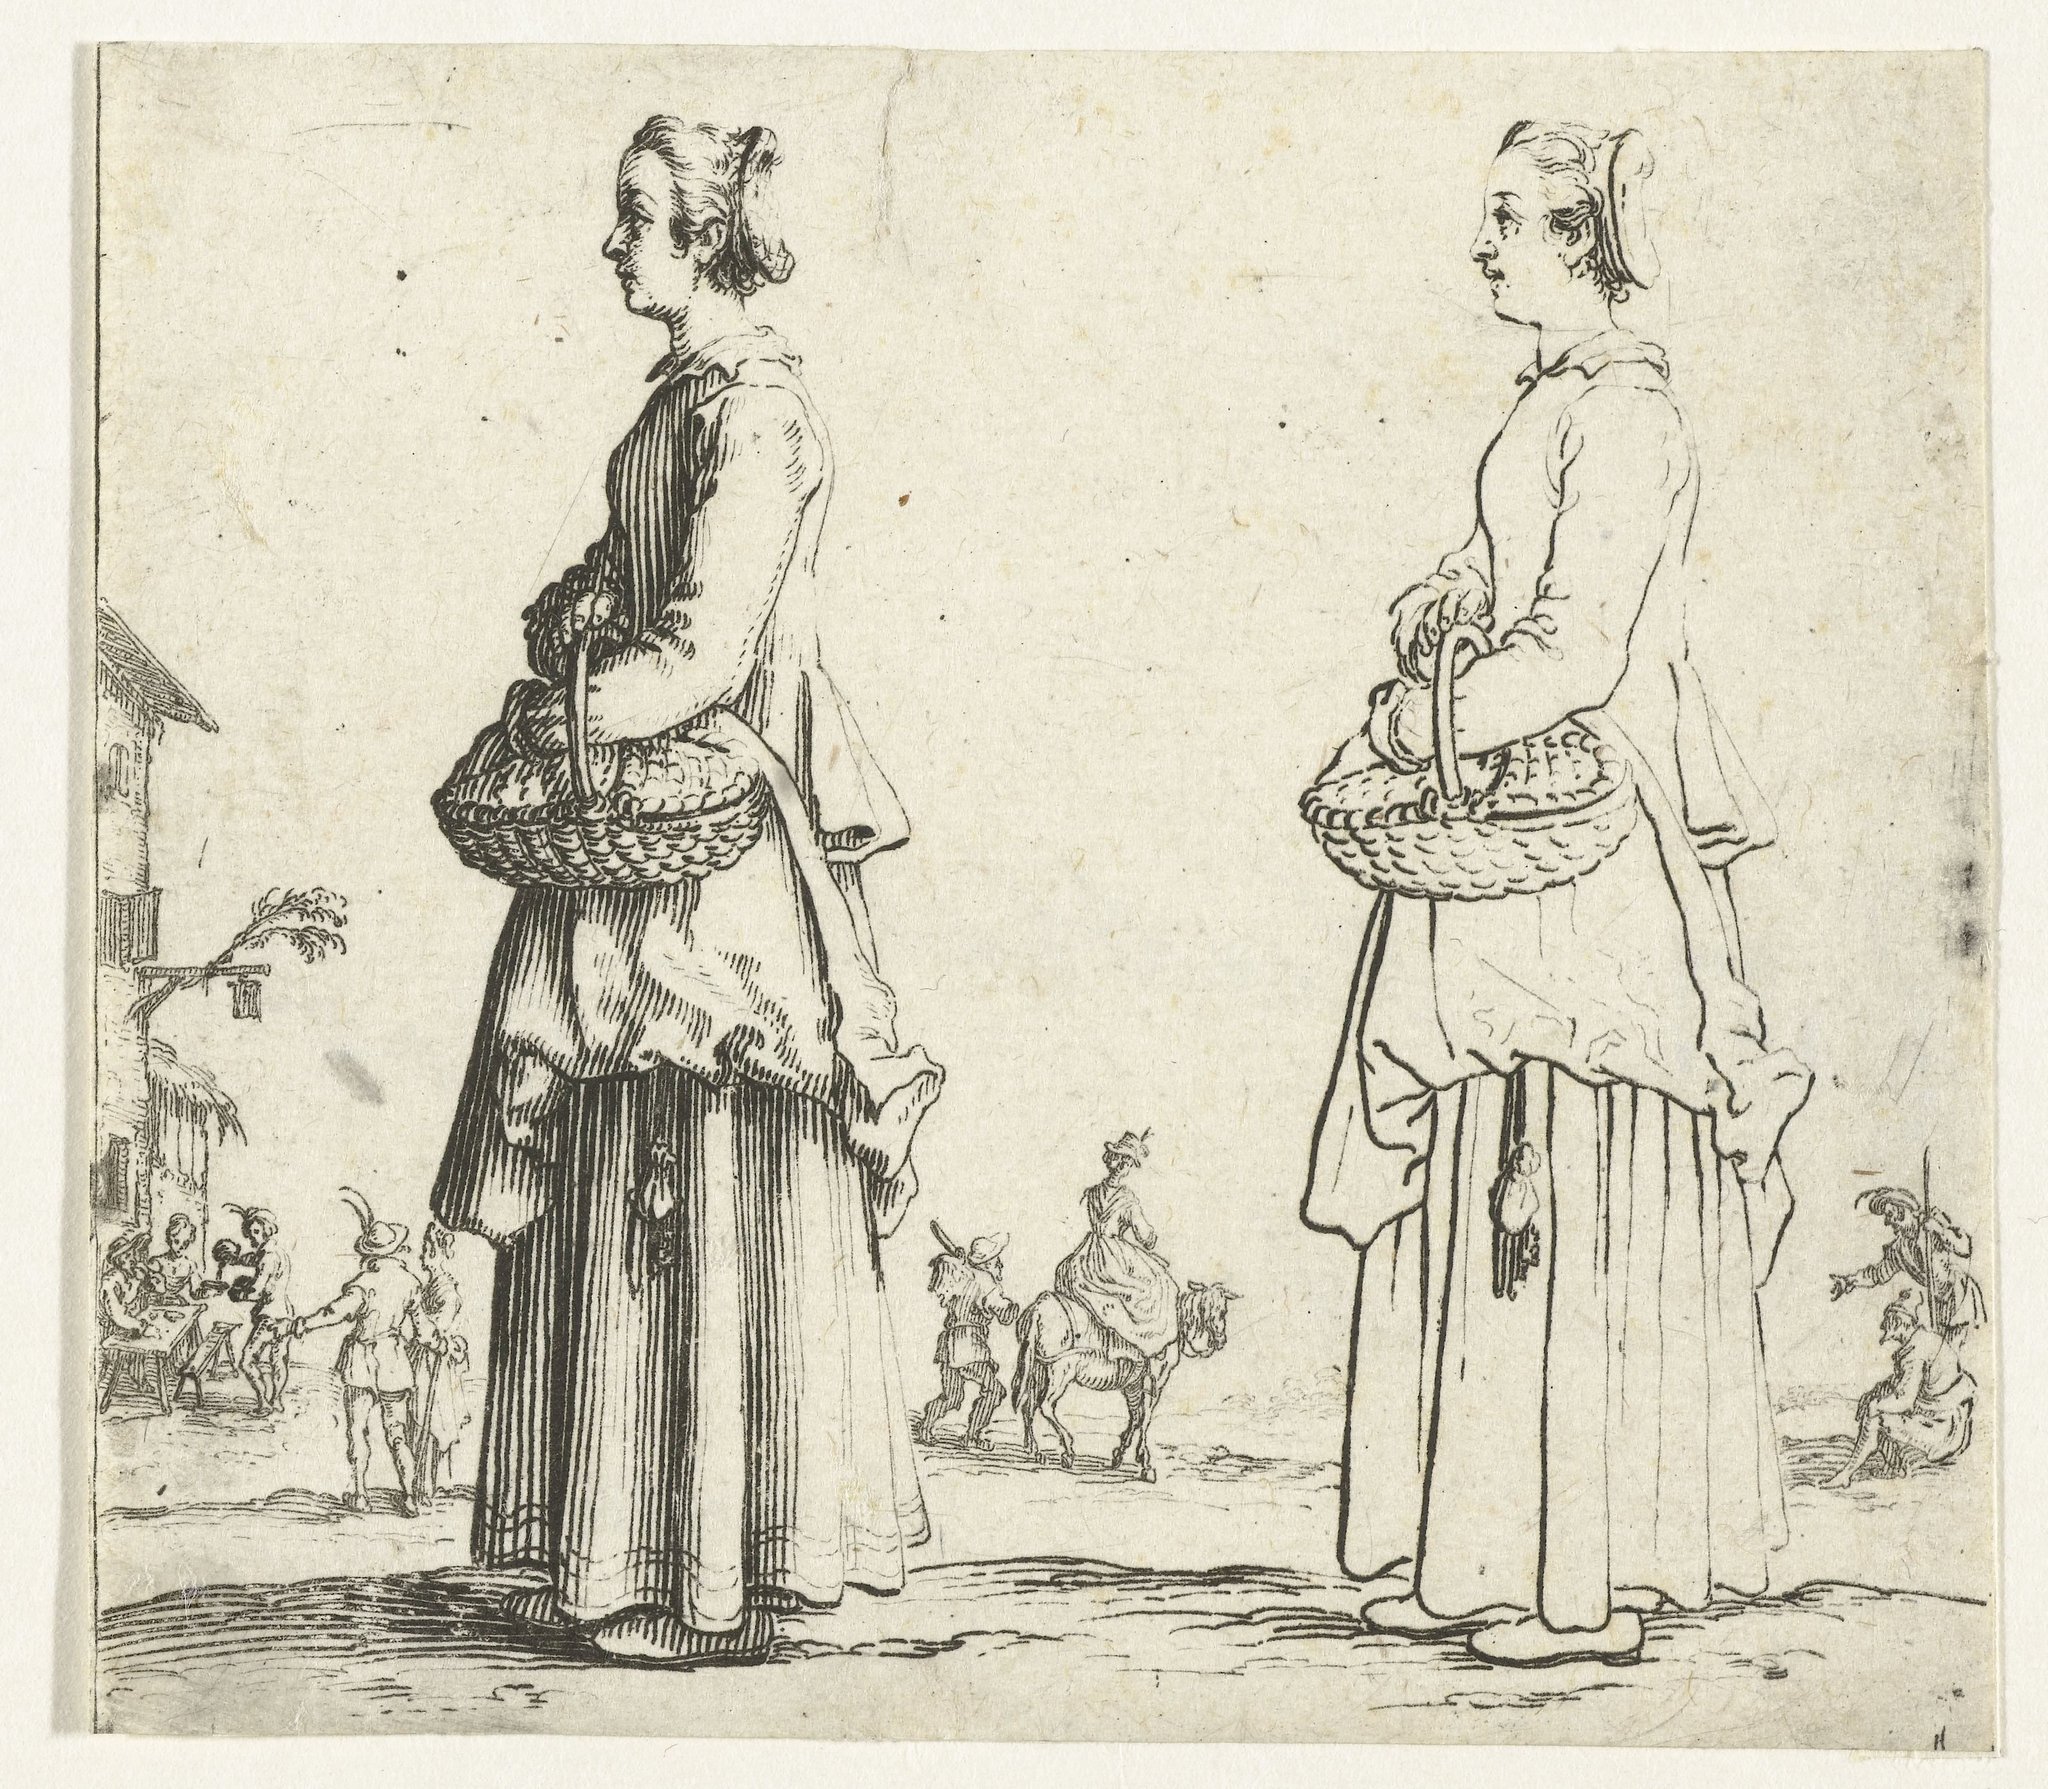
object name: print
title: Diverse figuren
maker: jacques callot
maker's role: draughtsman, print maker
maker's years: 1592-1635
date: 1621-1624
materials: paper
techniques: etching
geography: nancy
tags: farmers - aa - female farmer, farmer's wife, container made of plant material other than wood: basket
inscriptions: collector's mark: Lugt 240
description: Een boerin met een rieten mand aan de linkerarm, op de linkerzijde gezien, tweemaal afgebeeld: rechts als lijnfiguur, links meer uitgewerkt met schaduwpartijen. Op de achtergrond enkele figuurtjes bij een herberg. Deze prent is onderdeel van een serie van 16 prenten (15 volgens Lieure; 17 resp. 16 incl. titelprent) met mannen en vrouwen in diverse houdingen. Mogelijk zijn deze prenten bedoeld geweest als tekenvoorbeelden.